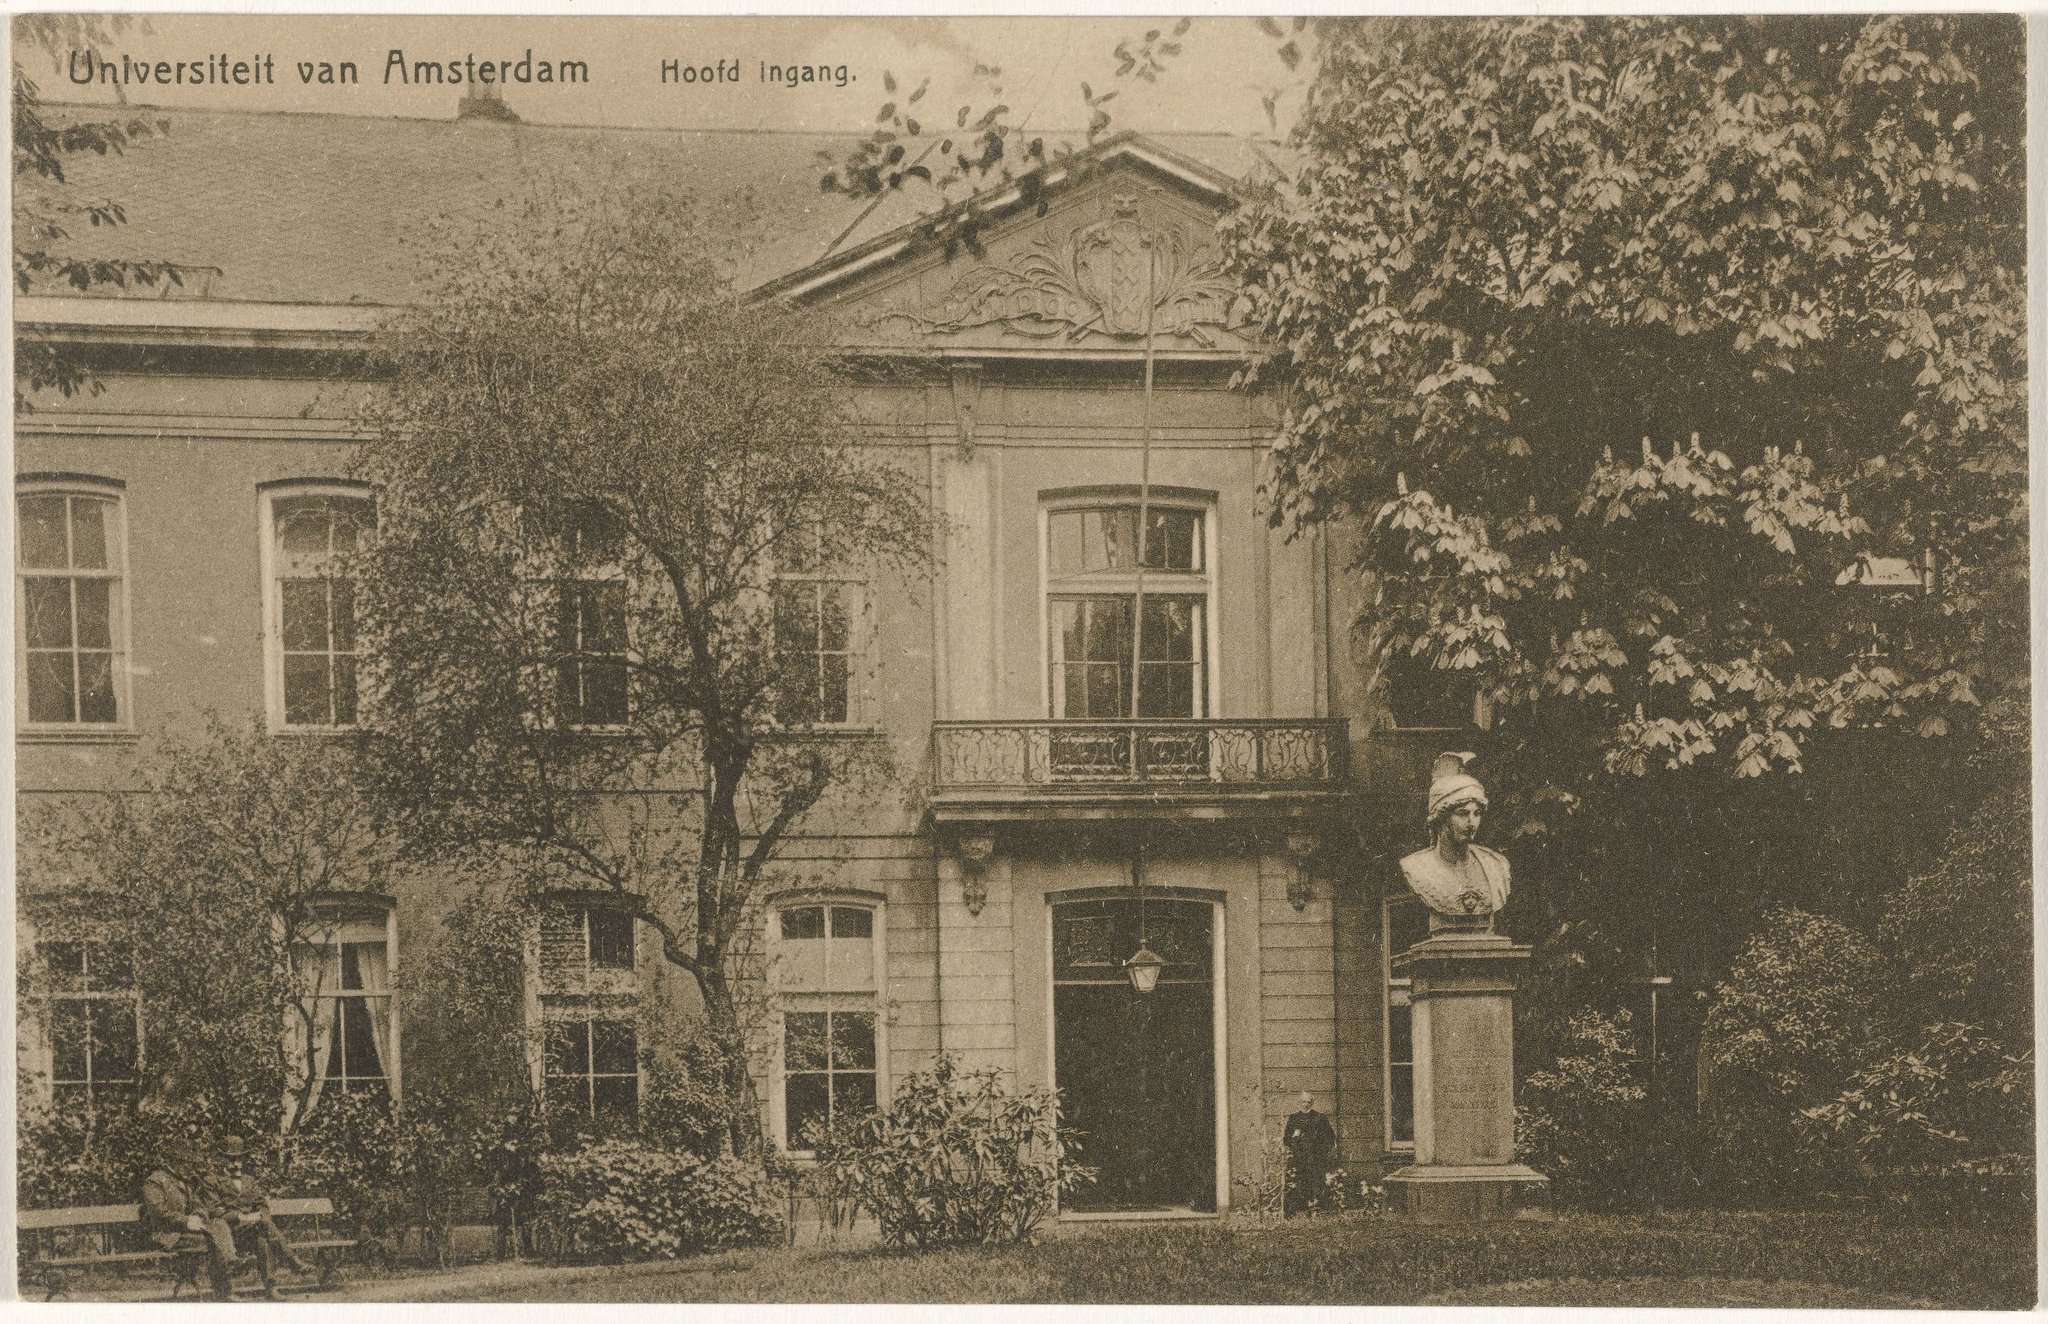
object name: photomechanical print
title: Universiteit van Amsterdam, hoofdingang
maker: Anonymous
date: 1907-1930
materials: cardboard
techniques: photograph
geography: amsterdam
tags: university building, college